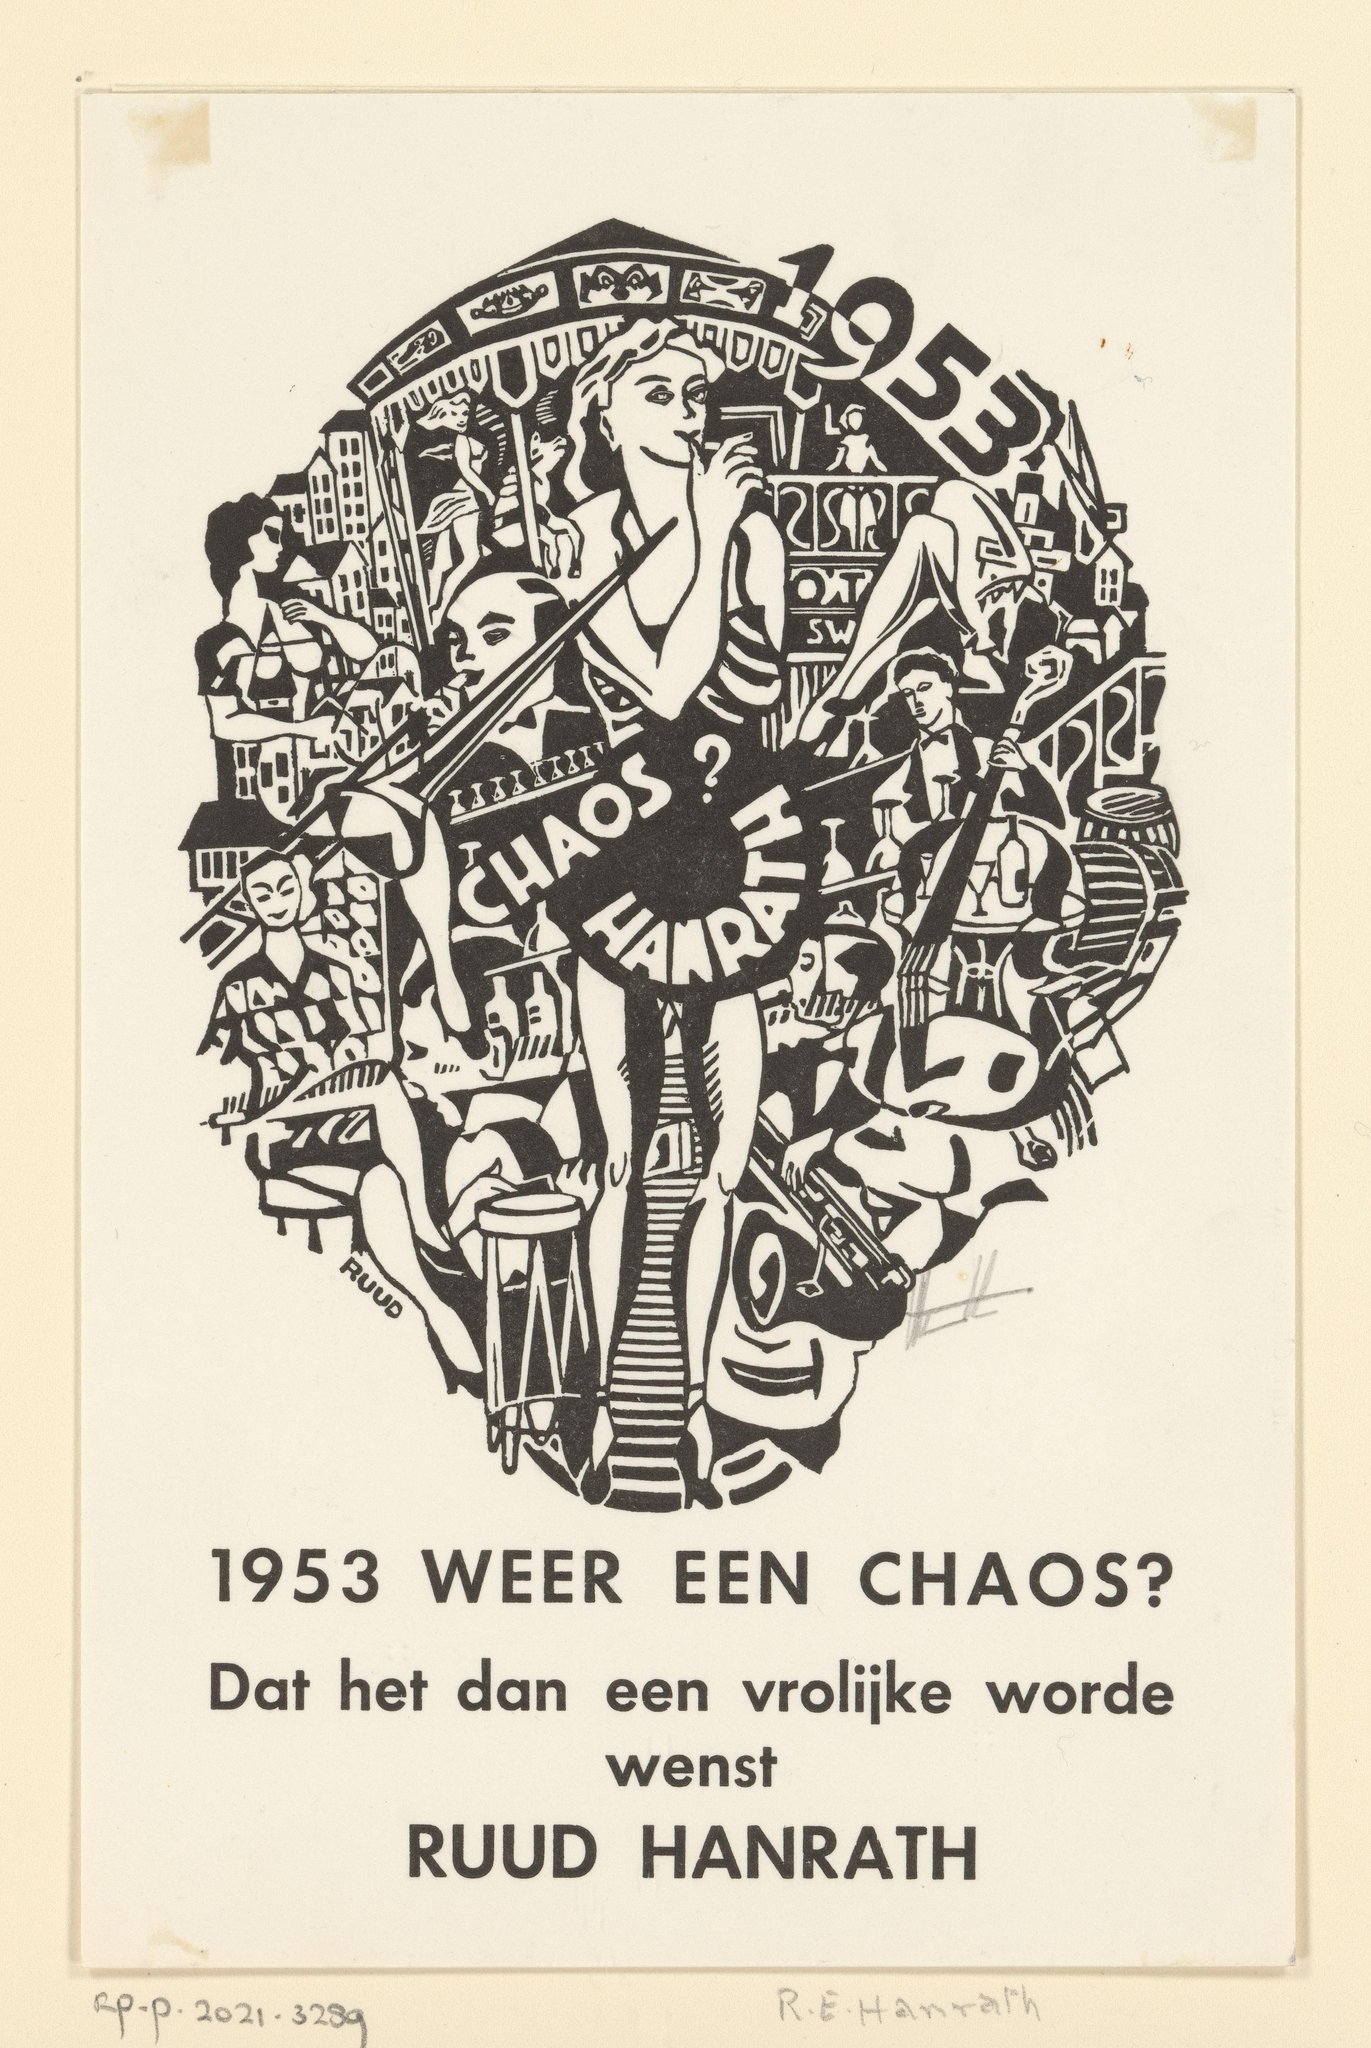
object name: new year card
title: Nieuwjaarswens voor 1953 van Rudolf Emond Hanrath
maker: rudolf emond hanrath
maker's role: print maker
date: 1952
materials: paper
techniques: scratchboard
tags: rudolf emond hanrath, small group of musicians, chamber orchestra, jazz band, adult woman, city-view in general; 'veduta'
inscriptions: workshop stamp: ‘R.E. Hanrath schaaftekening’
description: Samengestelde afbeelding van diverse figuren en gebouwen met daarin verwerkt het jaartal 1953 en de woorden: 'Chaos? Hanrath'. Daaronder de tekst: '1953 weer een chaos? Dat het dan een vrolijke worde wenst Ruud Hanrath'.